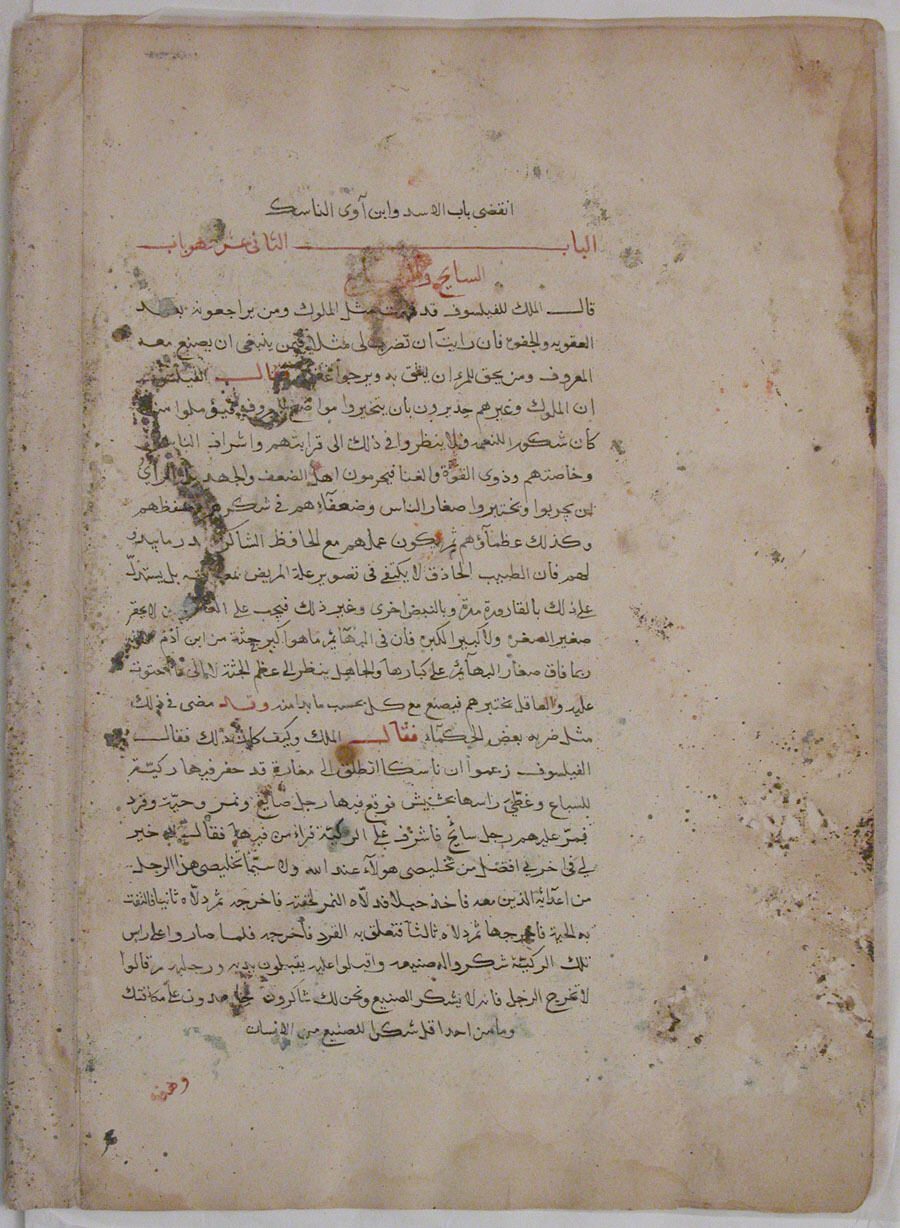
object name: folio from an illustrated manuscript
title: Page of Calligraphy from a Kalila wa Dimna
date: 1526-1550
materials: ink, paper, watercolor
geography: india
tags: arabic,calligraphy